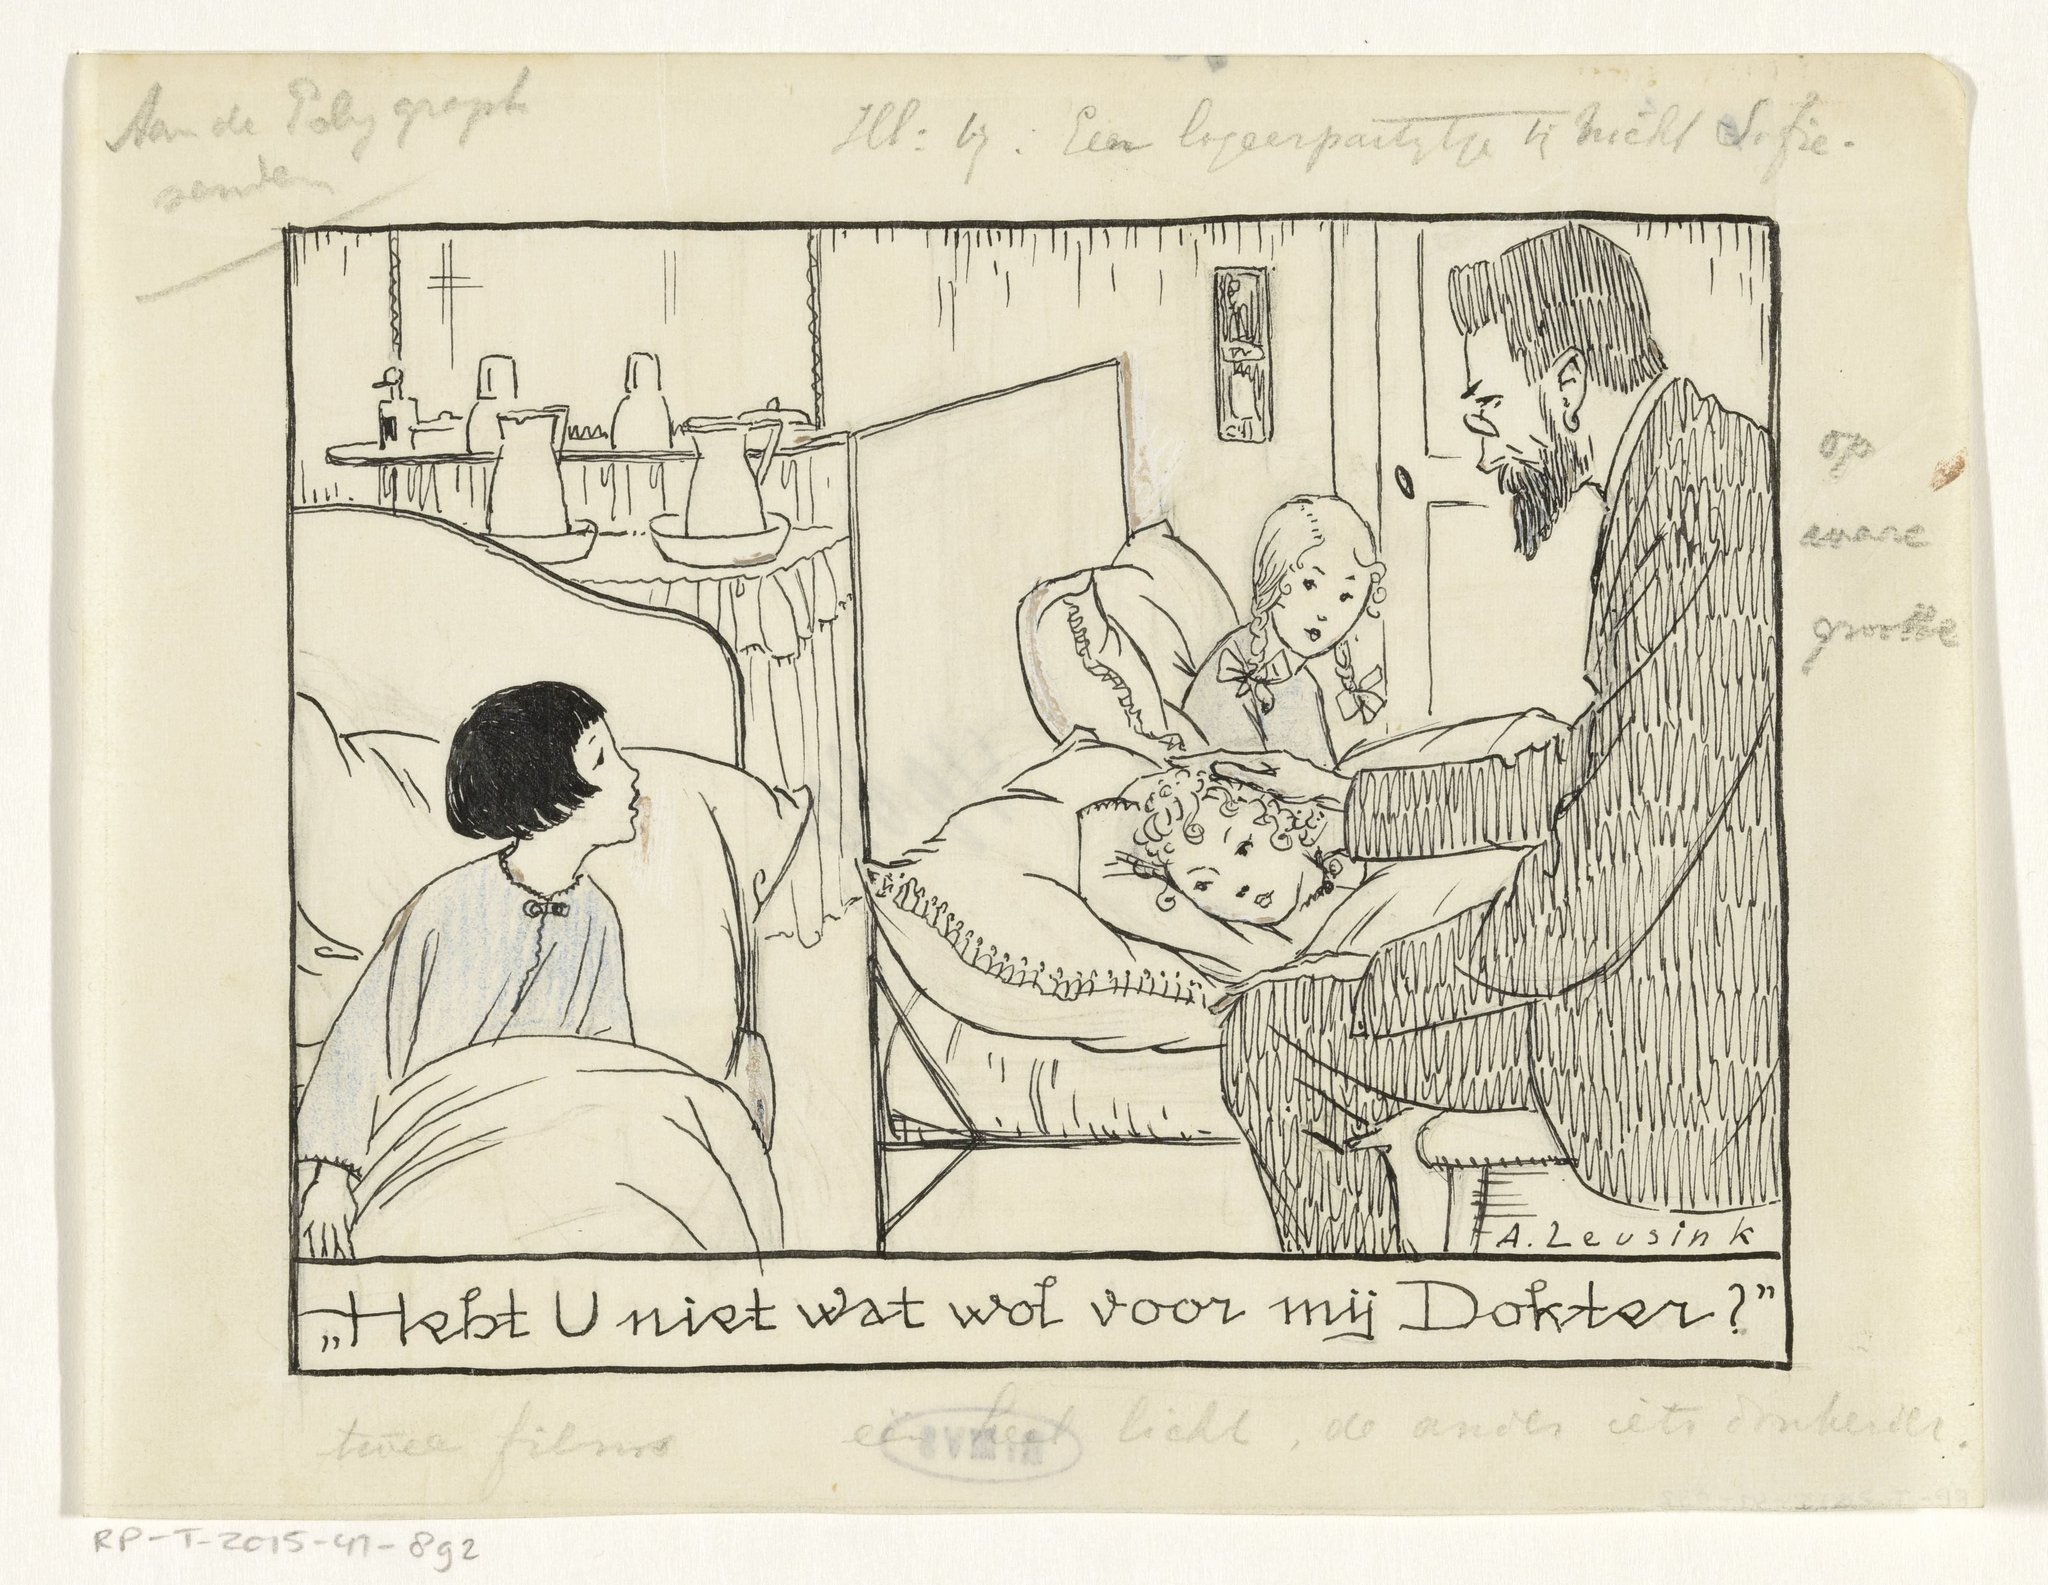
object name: boekillustratie ontwerp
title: Hebt u niet wat wol voor mij Dokter?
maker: anny leusink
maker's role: draughtsman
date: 1920-1930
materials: paint, ink, pencil, paper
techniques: brush, pen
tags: sick-bed, girl (child between toddler and youth), physician, doctor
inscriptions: :, signature: ‘A. Leusink’, annotation: ‘Aan de Polygraph/ zenden/ Ill: bij: Een logeerpartijtje bij nicht Sofie.’, collector's mark: Lugt 2228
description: Een dokter zit aan de rand van het bed van een ziek meisje en legt zijn hand op haar hoofd. In de kamer liggen nog twee meisjes in bed. Zij kijken naar de dokter.